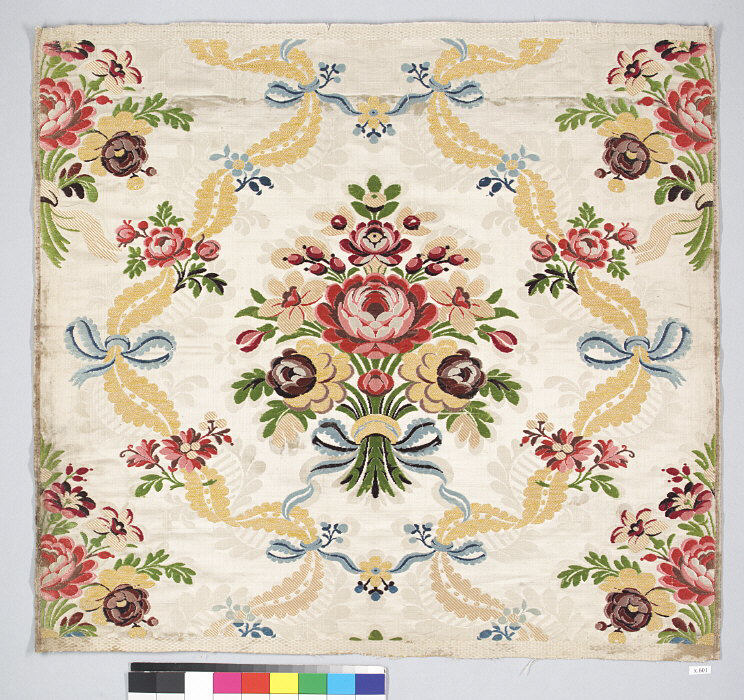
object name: piece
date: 1701-1900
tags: flowers,leaves